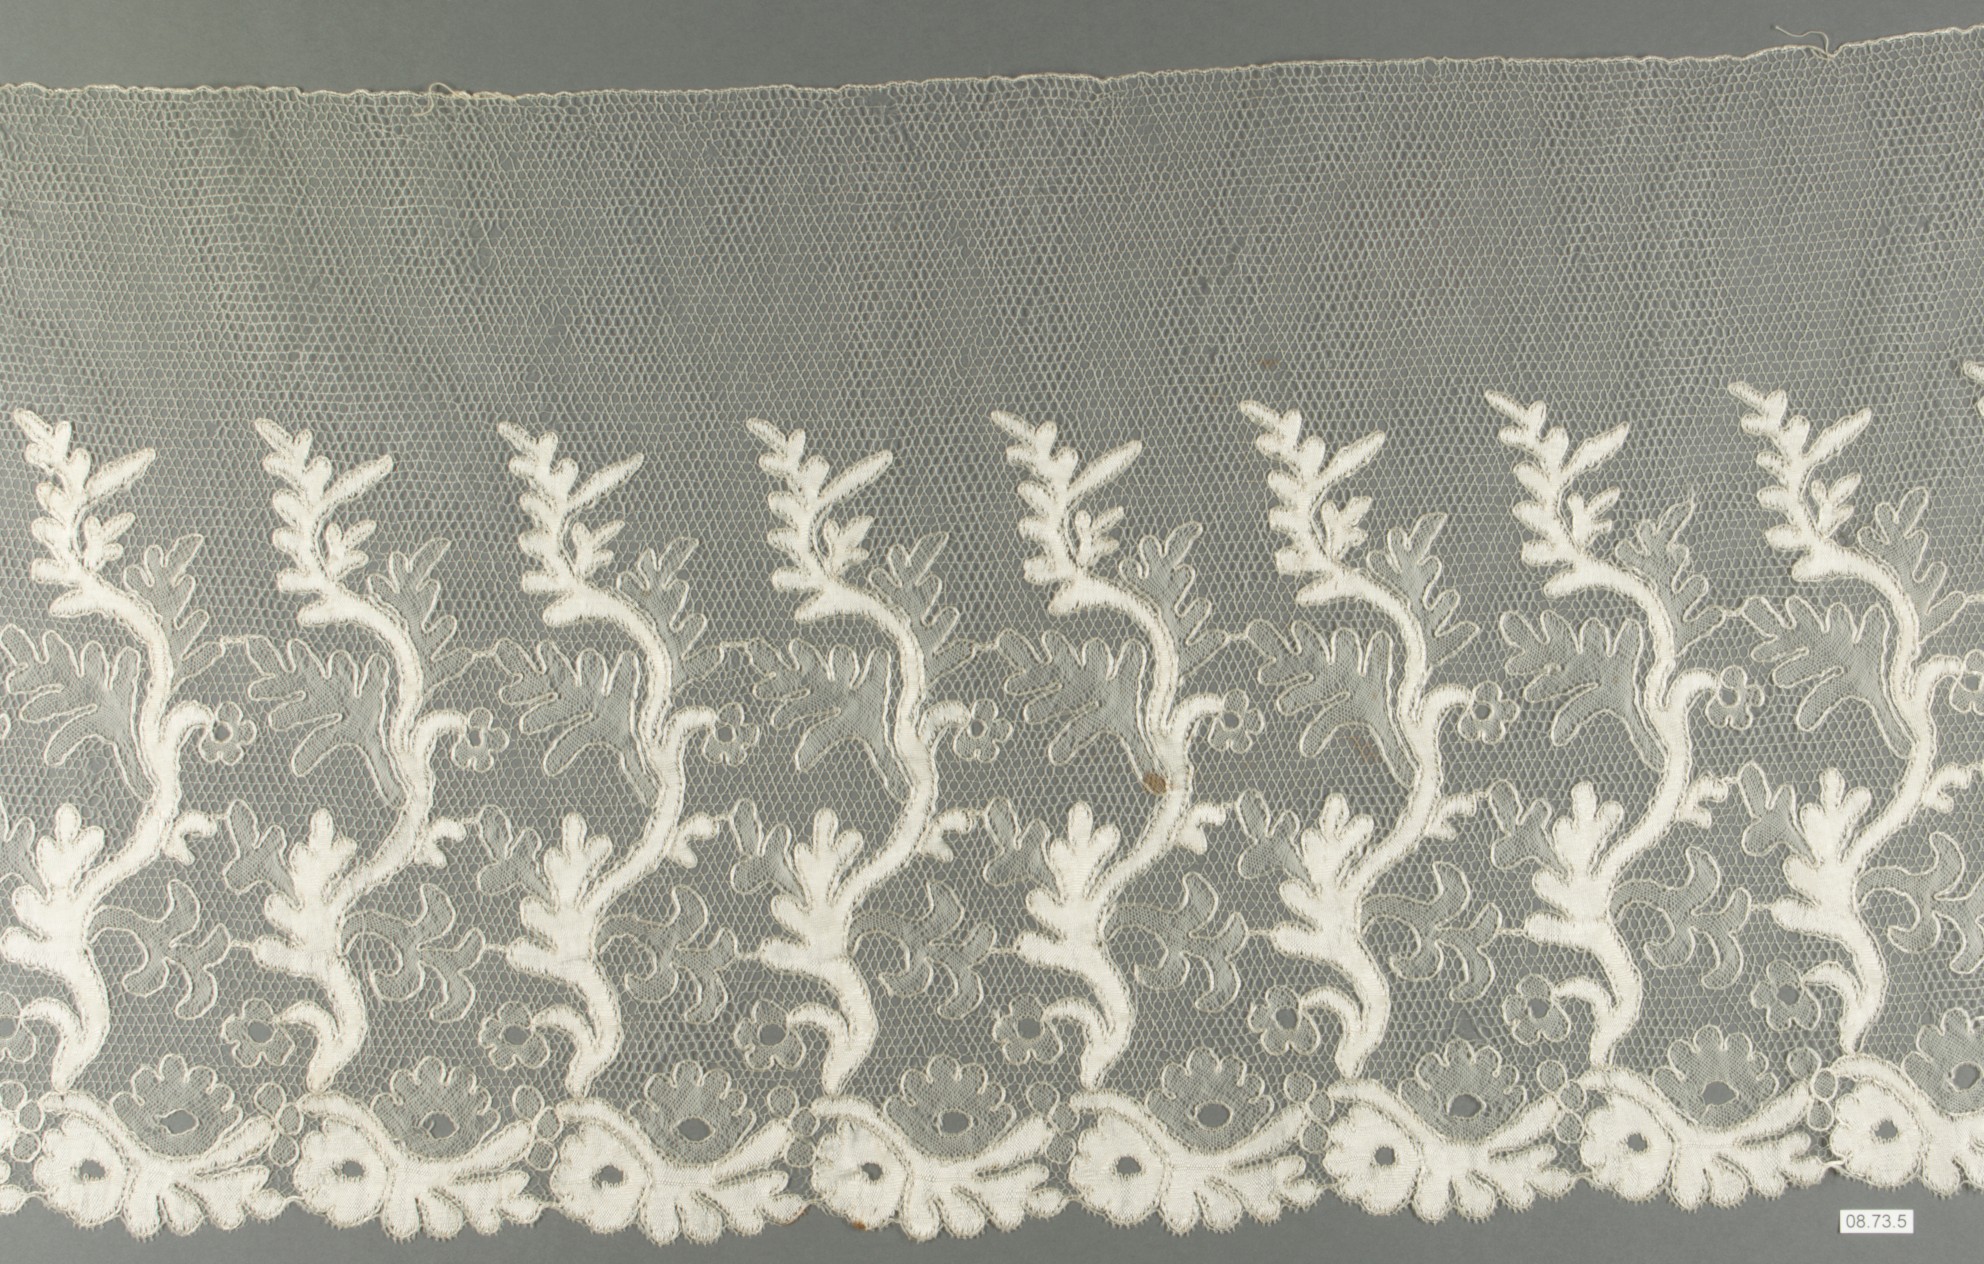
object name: piece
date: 1767-1800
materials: silk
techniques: lace